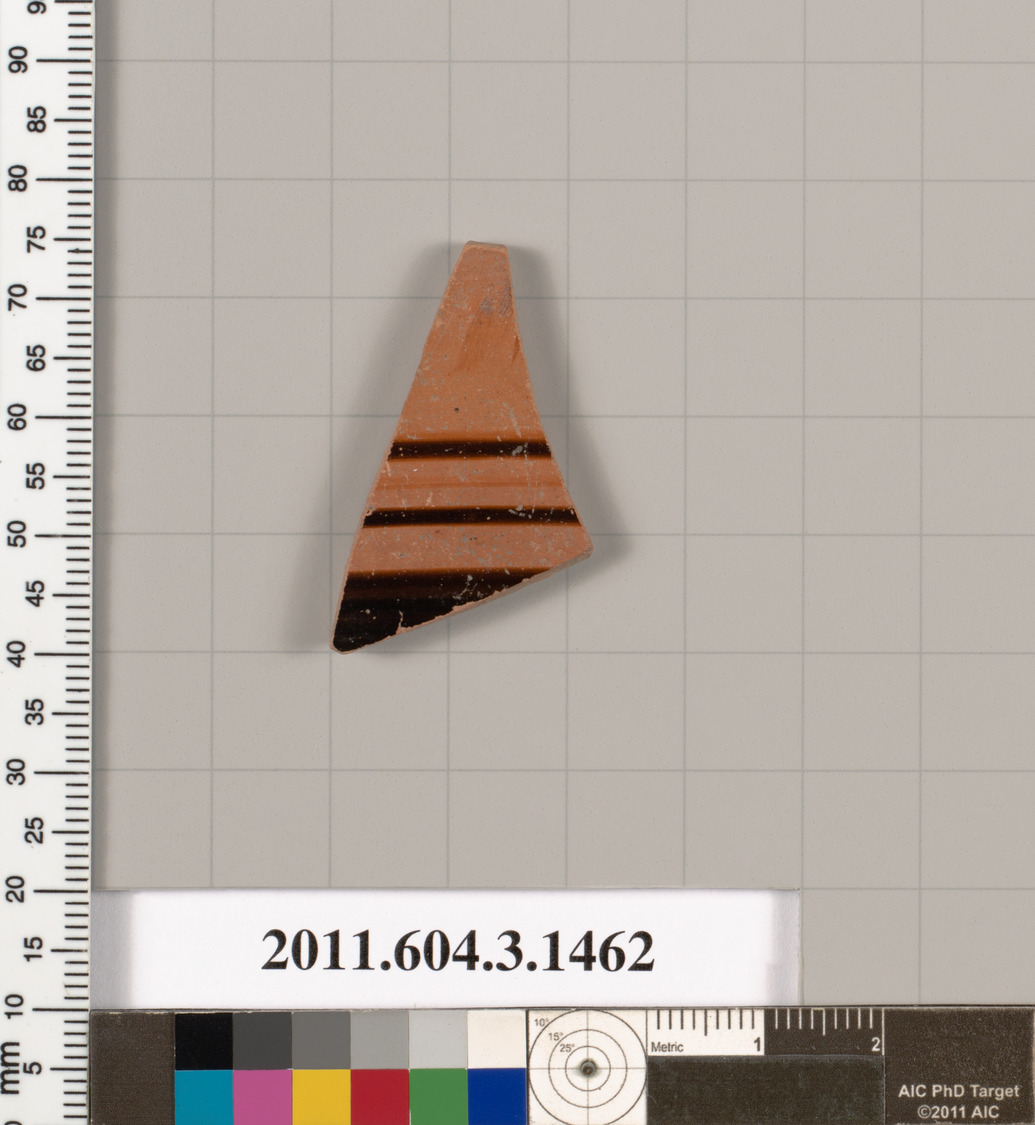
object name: skyphos fragment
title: Terracotta fragment of a skyphos (deep drinking cup)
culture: greek, attic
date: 600-401 BCE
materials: terracotta